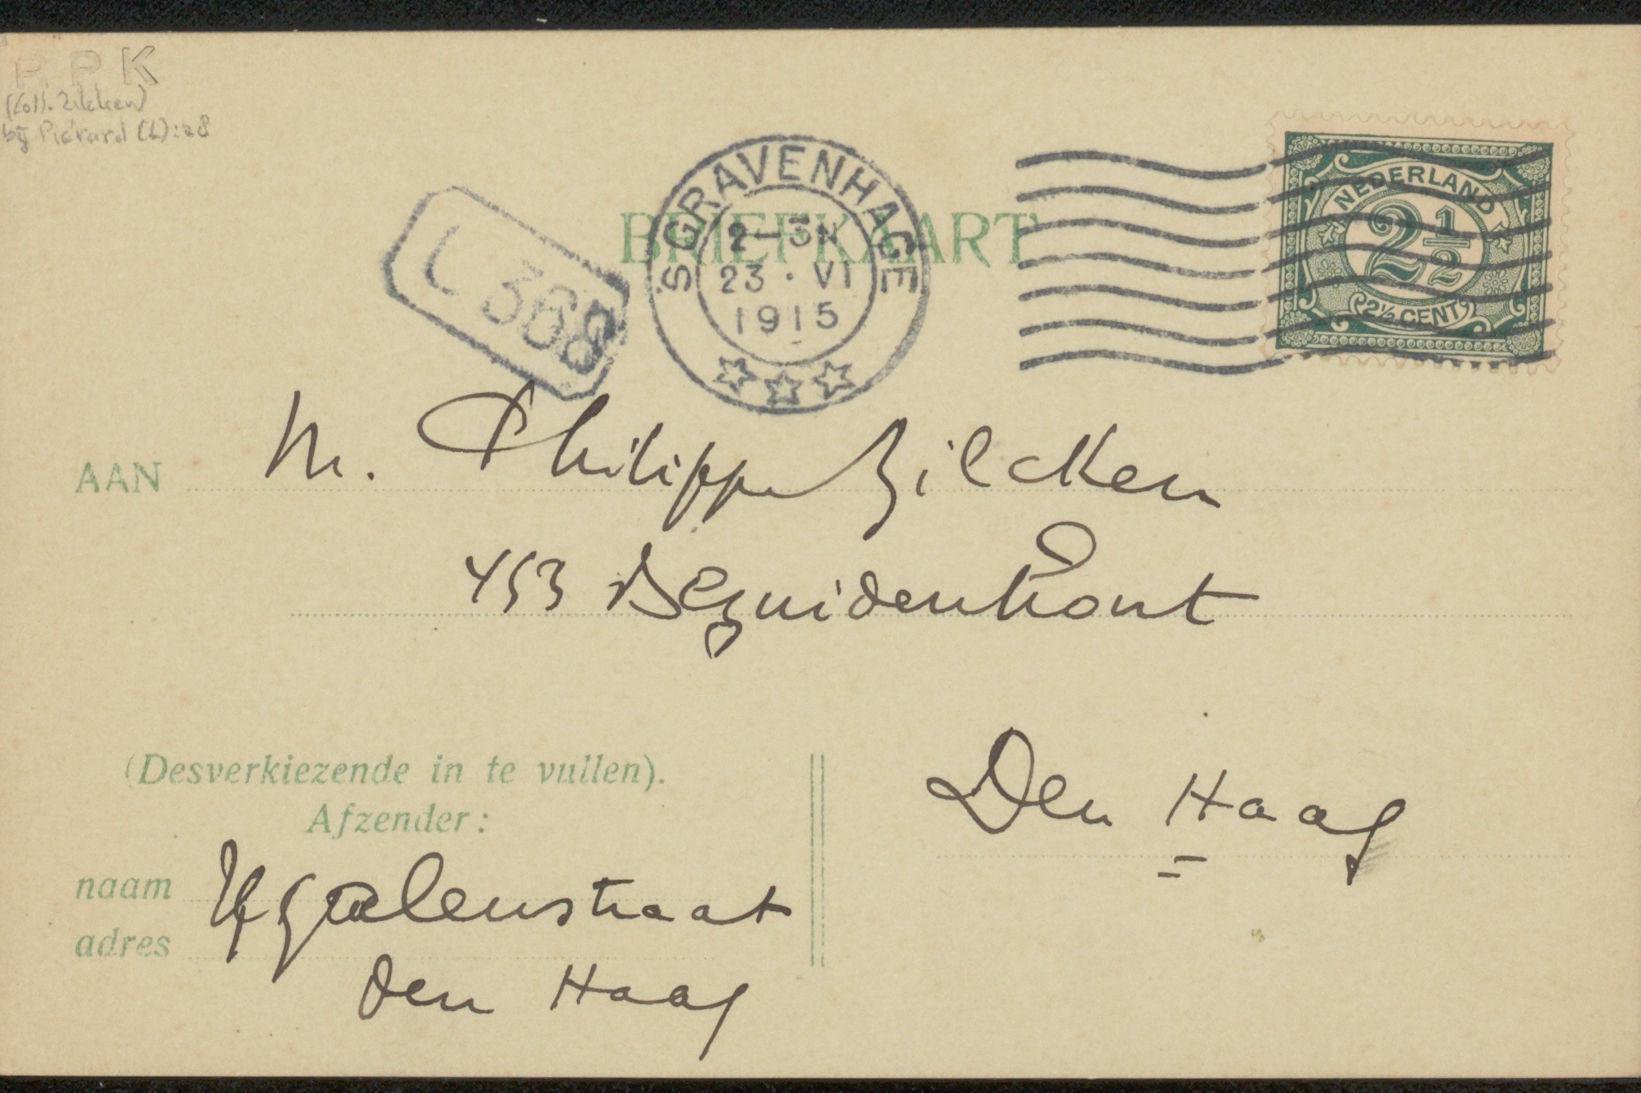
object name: postcard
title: Briefkaart aan Philip Zilcken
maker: louis piérard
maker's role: letterkundige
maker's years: 1886-1951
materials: cardboard, ink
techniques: pen, writing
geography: the hague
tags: painter, draughtsman, philip zilcken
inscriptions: collector's mark: ‘RPK’